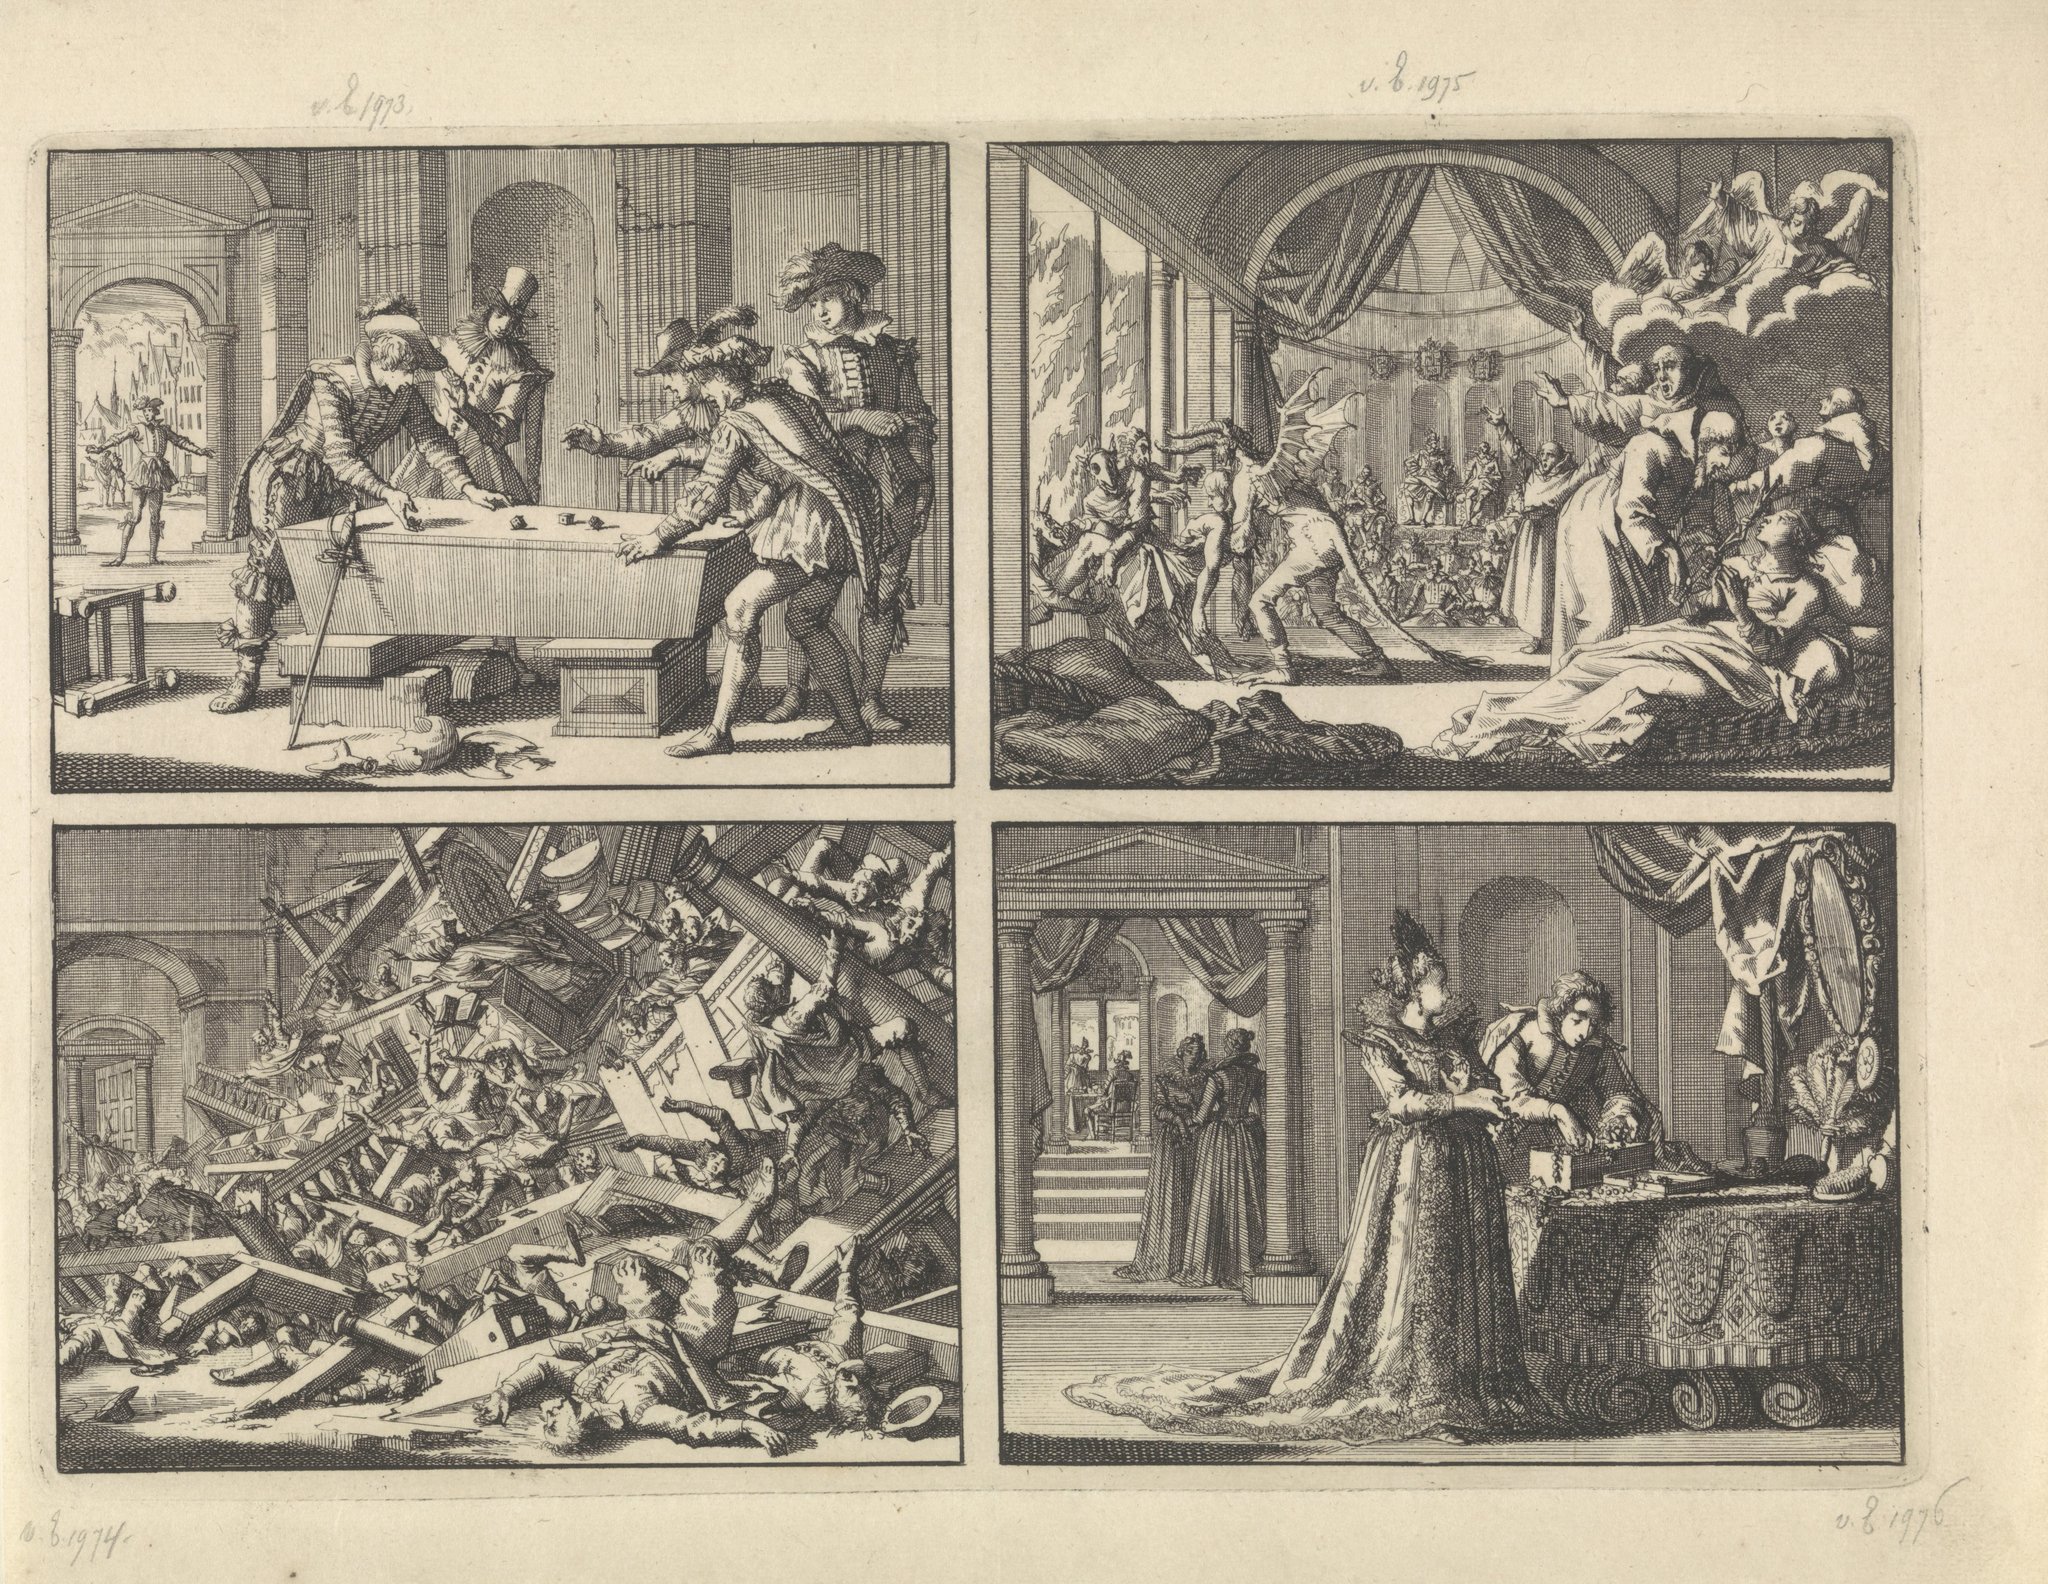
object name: print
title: Lakeien dobbelen op de lijkkist van de hertog van Luynes, 1621 / Satyrische toneelvoorstelling door koning Filips IV van Spanje gegeven aan zijn gast Karel I van Engeland, 1623 / Ingestorte galerij tijdens een katholieke godsdienstoefening in het huis van de Spaanse gezant te Londen, 1623 / Vermomd als juwelier brengt Gustaaf II Adolf zijn eerste bezoek aan zijn verloofde Maria Eleonora van Brandenburg, 1620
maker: jan luyken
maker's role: draughtsman, print maker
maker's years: 1649-1712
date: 1698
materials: paper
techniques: etching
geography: amsterdam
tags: filips iv (koning van spanje), london, karel i (koning van engeland), lackey and other lower personnel at court, jeweller, goldsmith, silversmith, coffin, dice-games, disguise, collapsing building, satyr play, farce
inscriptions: collector's mark: Lugt 2228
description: Prenten gebruikt als illustratie in: Gottfried, Johann Ludwig. Historische kronyck; vervattende een (...) beschrijvingh der aldergedenckwaerdigste geschiedenissen des weerelds, van den aenvangh der scheppingh tot (...) 1576 (2 delen). Leiden: Pieter van der Aa, 1698, dl. I, p. 703, 713, 711, 358.